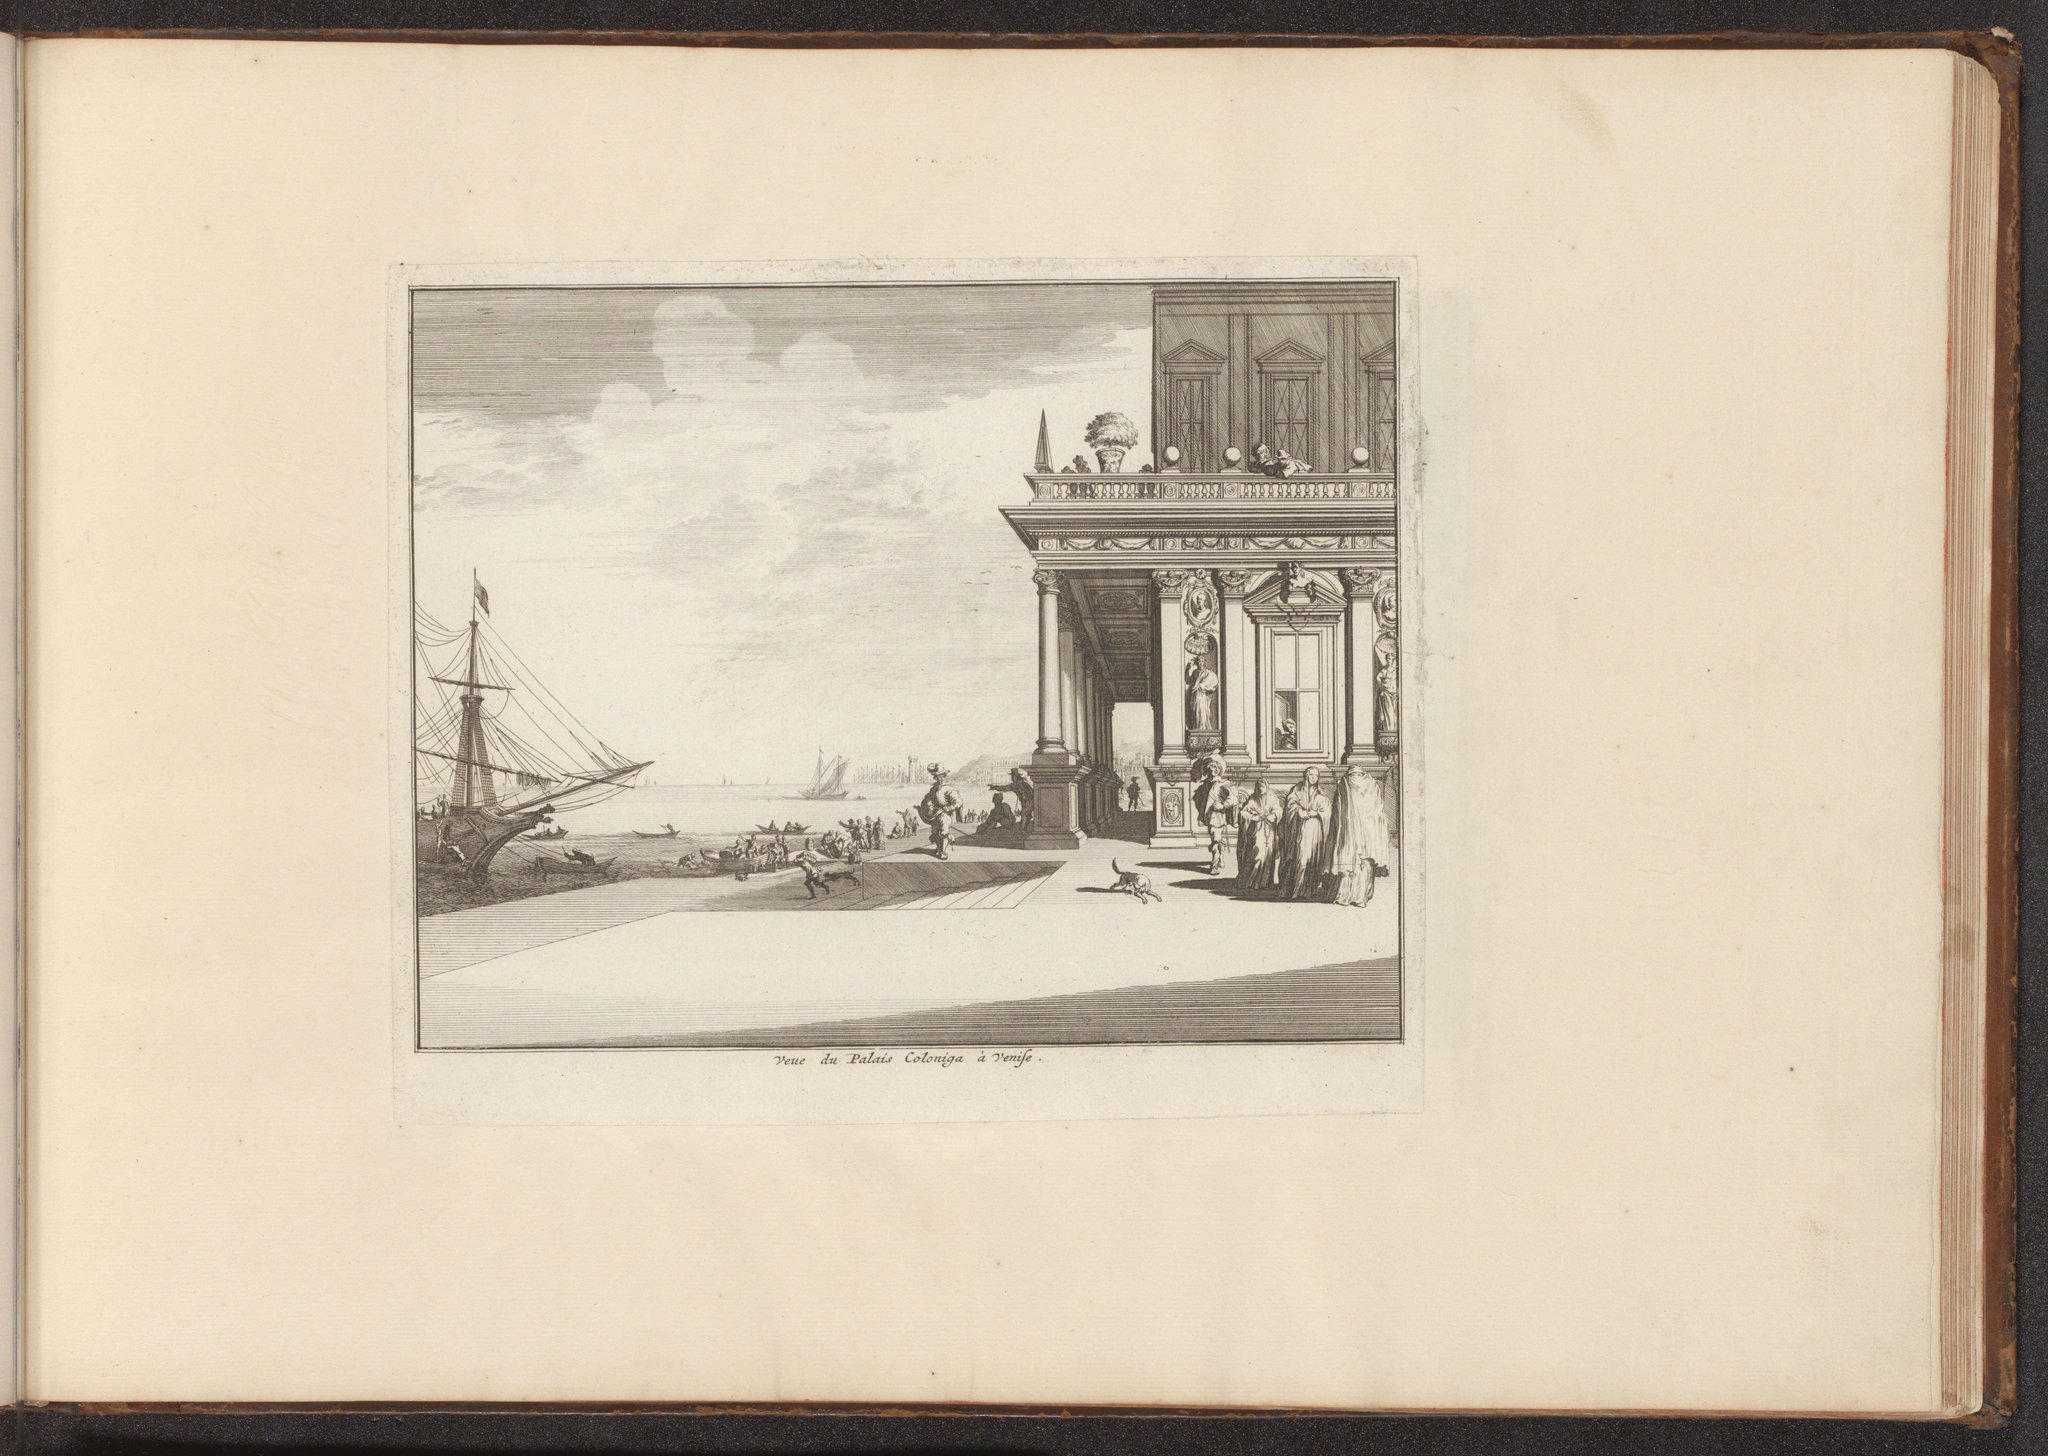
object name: album leaf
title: Gezicht op Palazzo Colinga te Venetië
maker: Anonymous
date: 1700-1710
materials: paper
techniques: etching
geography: france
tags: hôtel, i.e. small palace in city, gondola, venice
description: Gezicht op Palazzo Colinga aan de waterkant in Venetië. Op het water varen verschillende schepen. De prent maakt deel uit van een album.